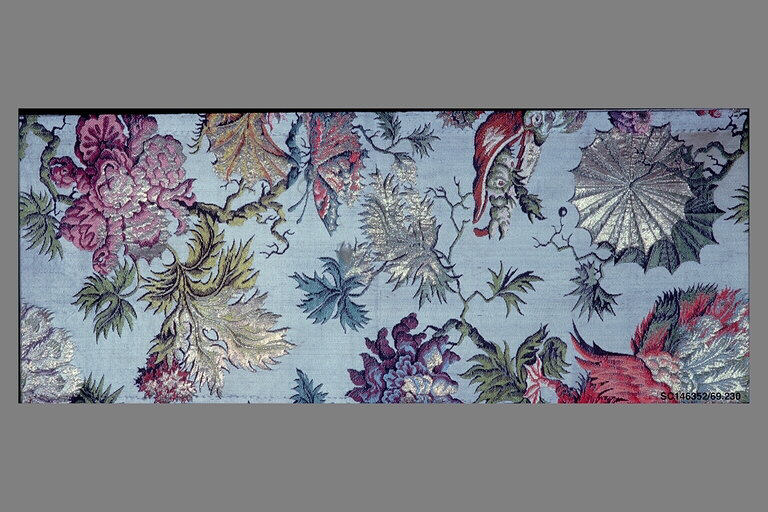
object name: piece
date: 1701-1800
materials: gold, silk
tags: flowers,leaves